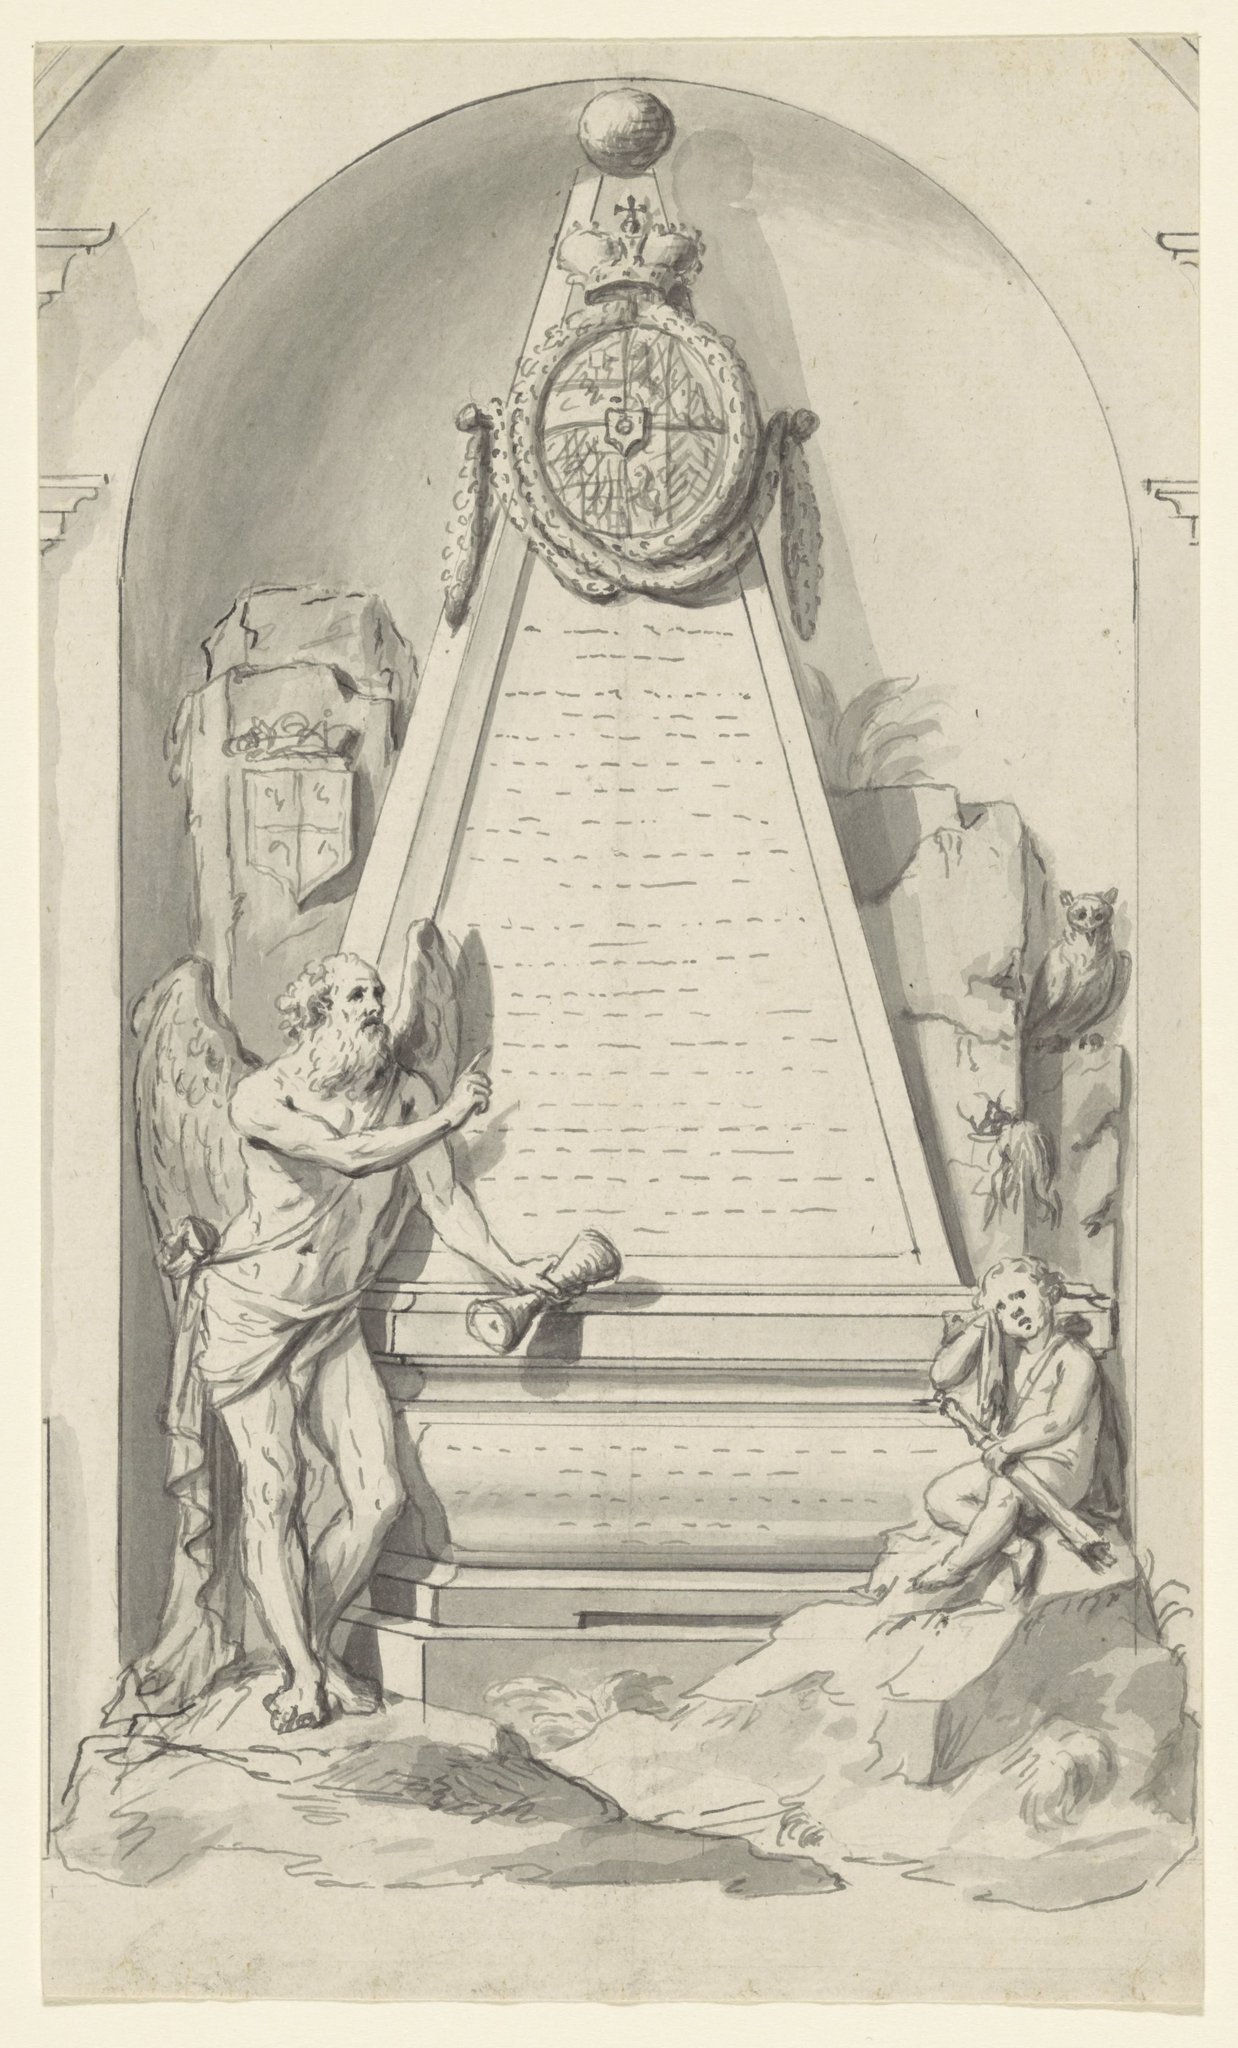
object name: drawing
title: Grafmonument met obelisk en Vader Tijd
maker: Anonymous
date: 1650-1800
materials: ink, paper, pencil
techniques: brush, pen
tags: grave, tomb, needle, obelisk (marking grave), father time, man with wings and scythe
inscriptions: collector's mark: Lugt 2228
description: Een grafmonument in een nis met een obelisk en Vader Tijd. Rechts zit een wenende putto. Aan de bovenzijde van de obelisk een gekroond wapenschild met guirlandes.